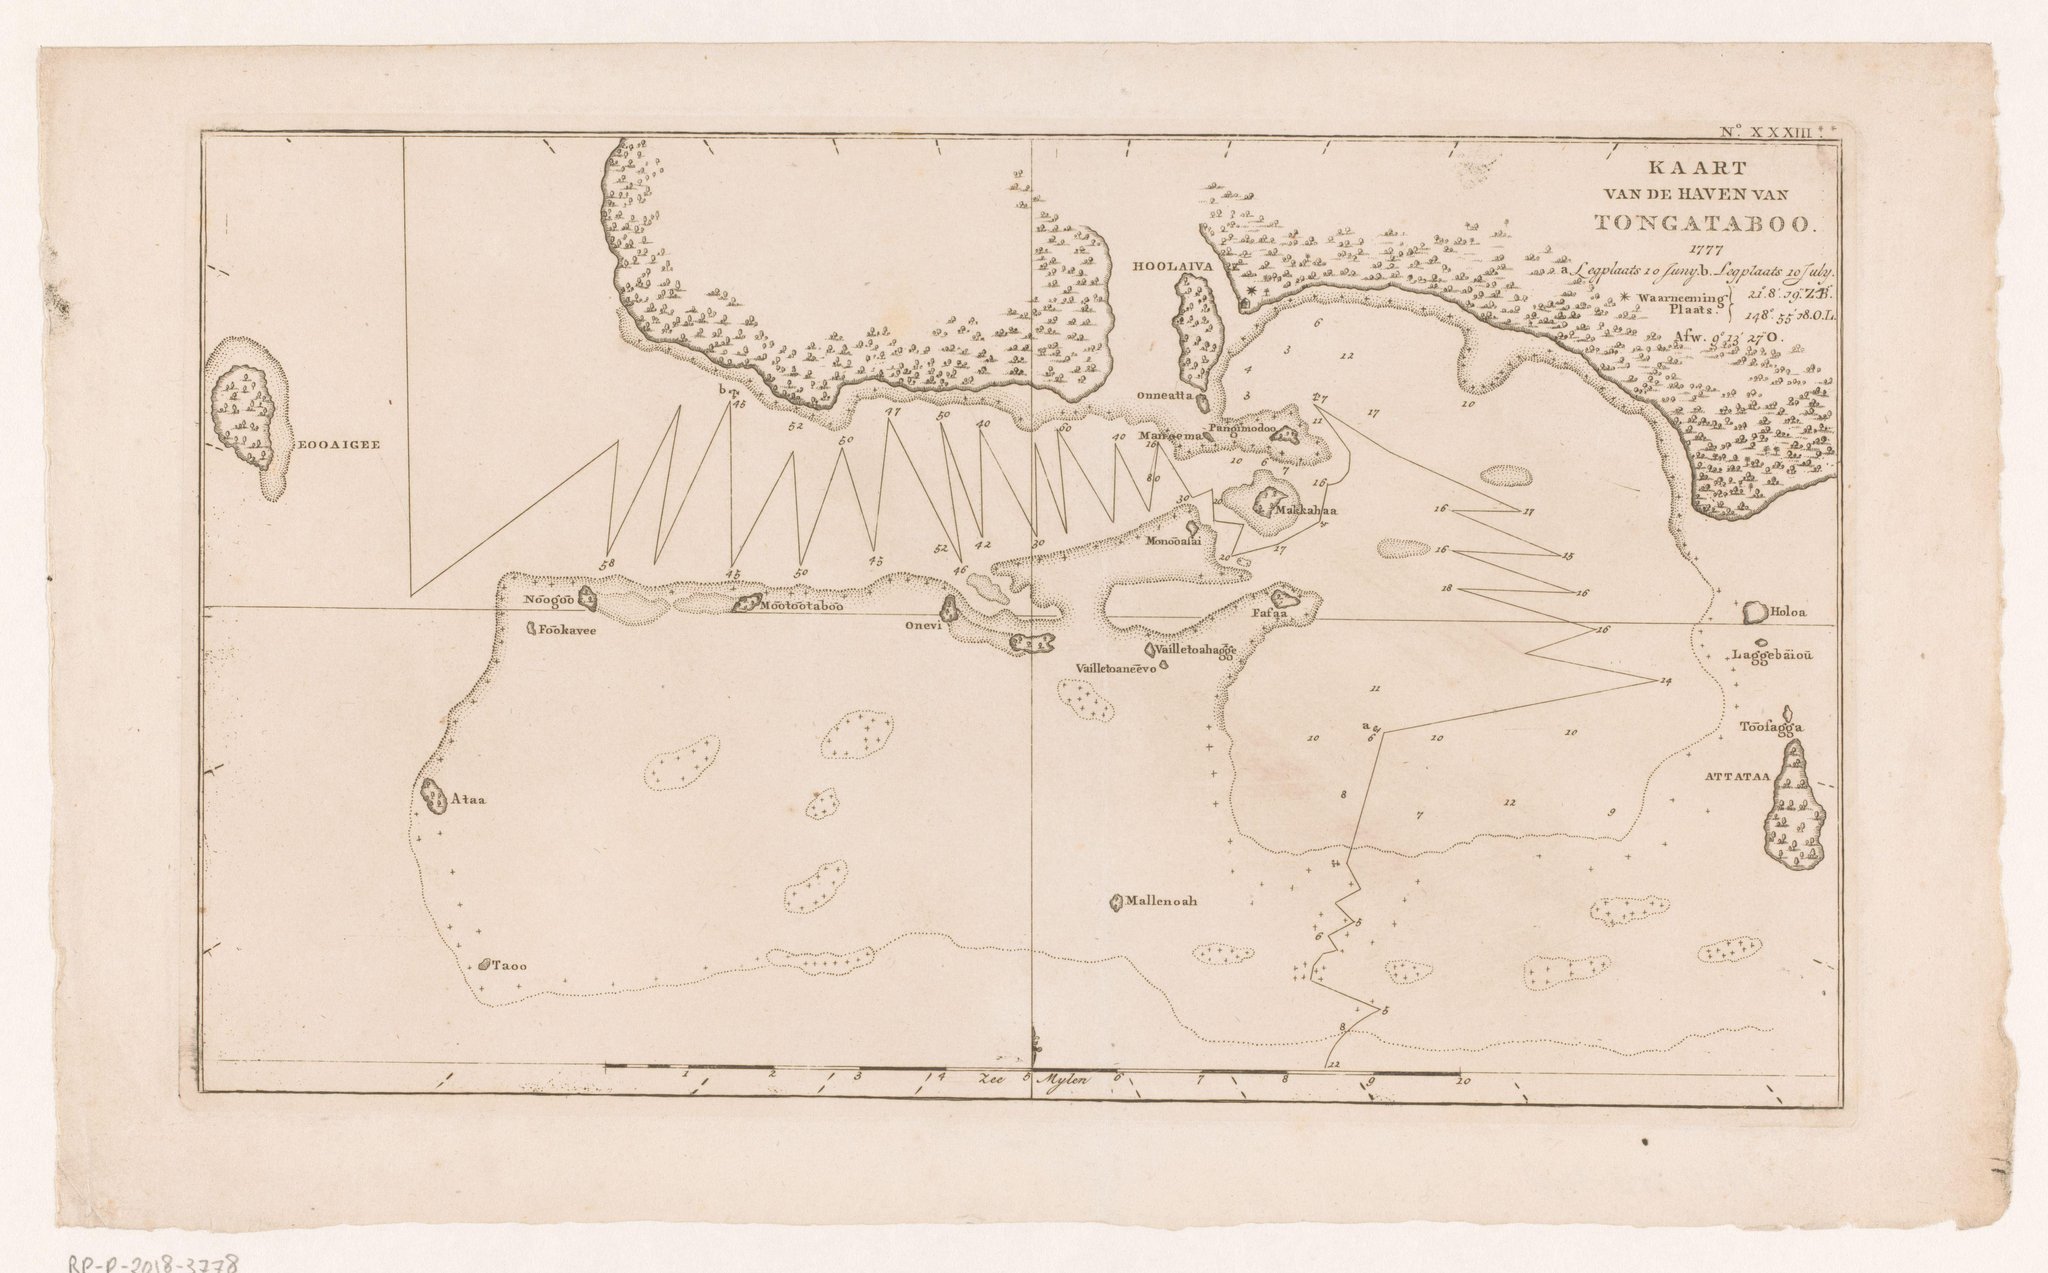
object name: print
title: Kaart van de kust van het eiland Tongatapu in de Grote Oceaan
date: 1801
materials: paper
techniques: etching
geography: leiden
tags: island, maps, atlases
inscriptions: collector's mark: Lugt 2228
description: Prent uit: Cook, James. Reize rondom de Waereld (...) met kaarten en plaaten. [Vertaald uit het Engels door] Jan David Pasteur. Leiden: Honkoop, Amsterdam: Allart, Den Haag: Van Cleef, 1801, dl. 9, p. 166.